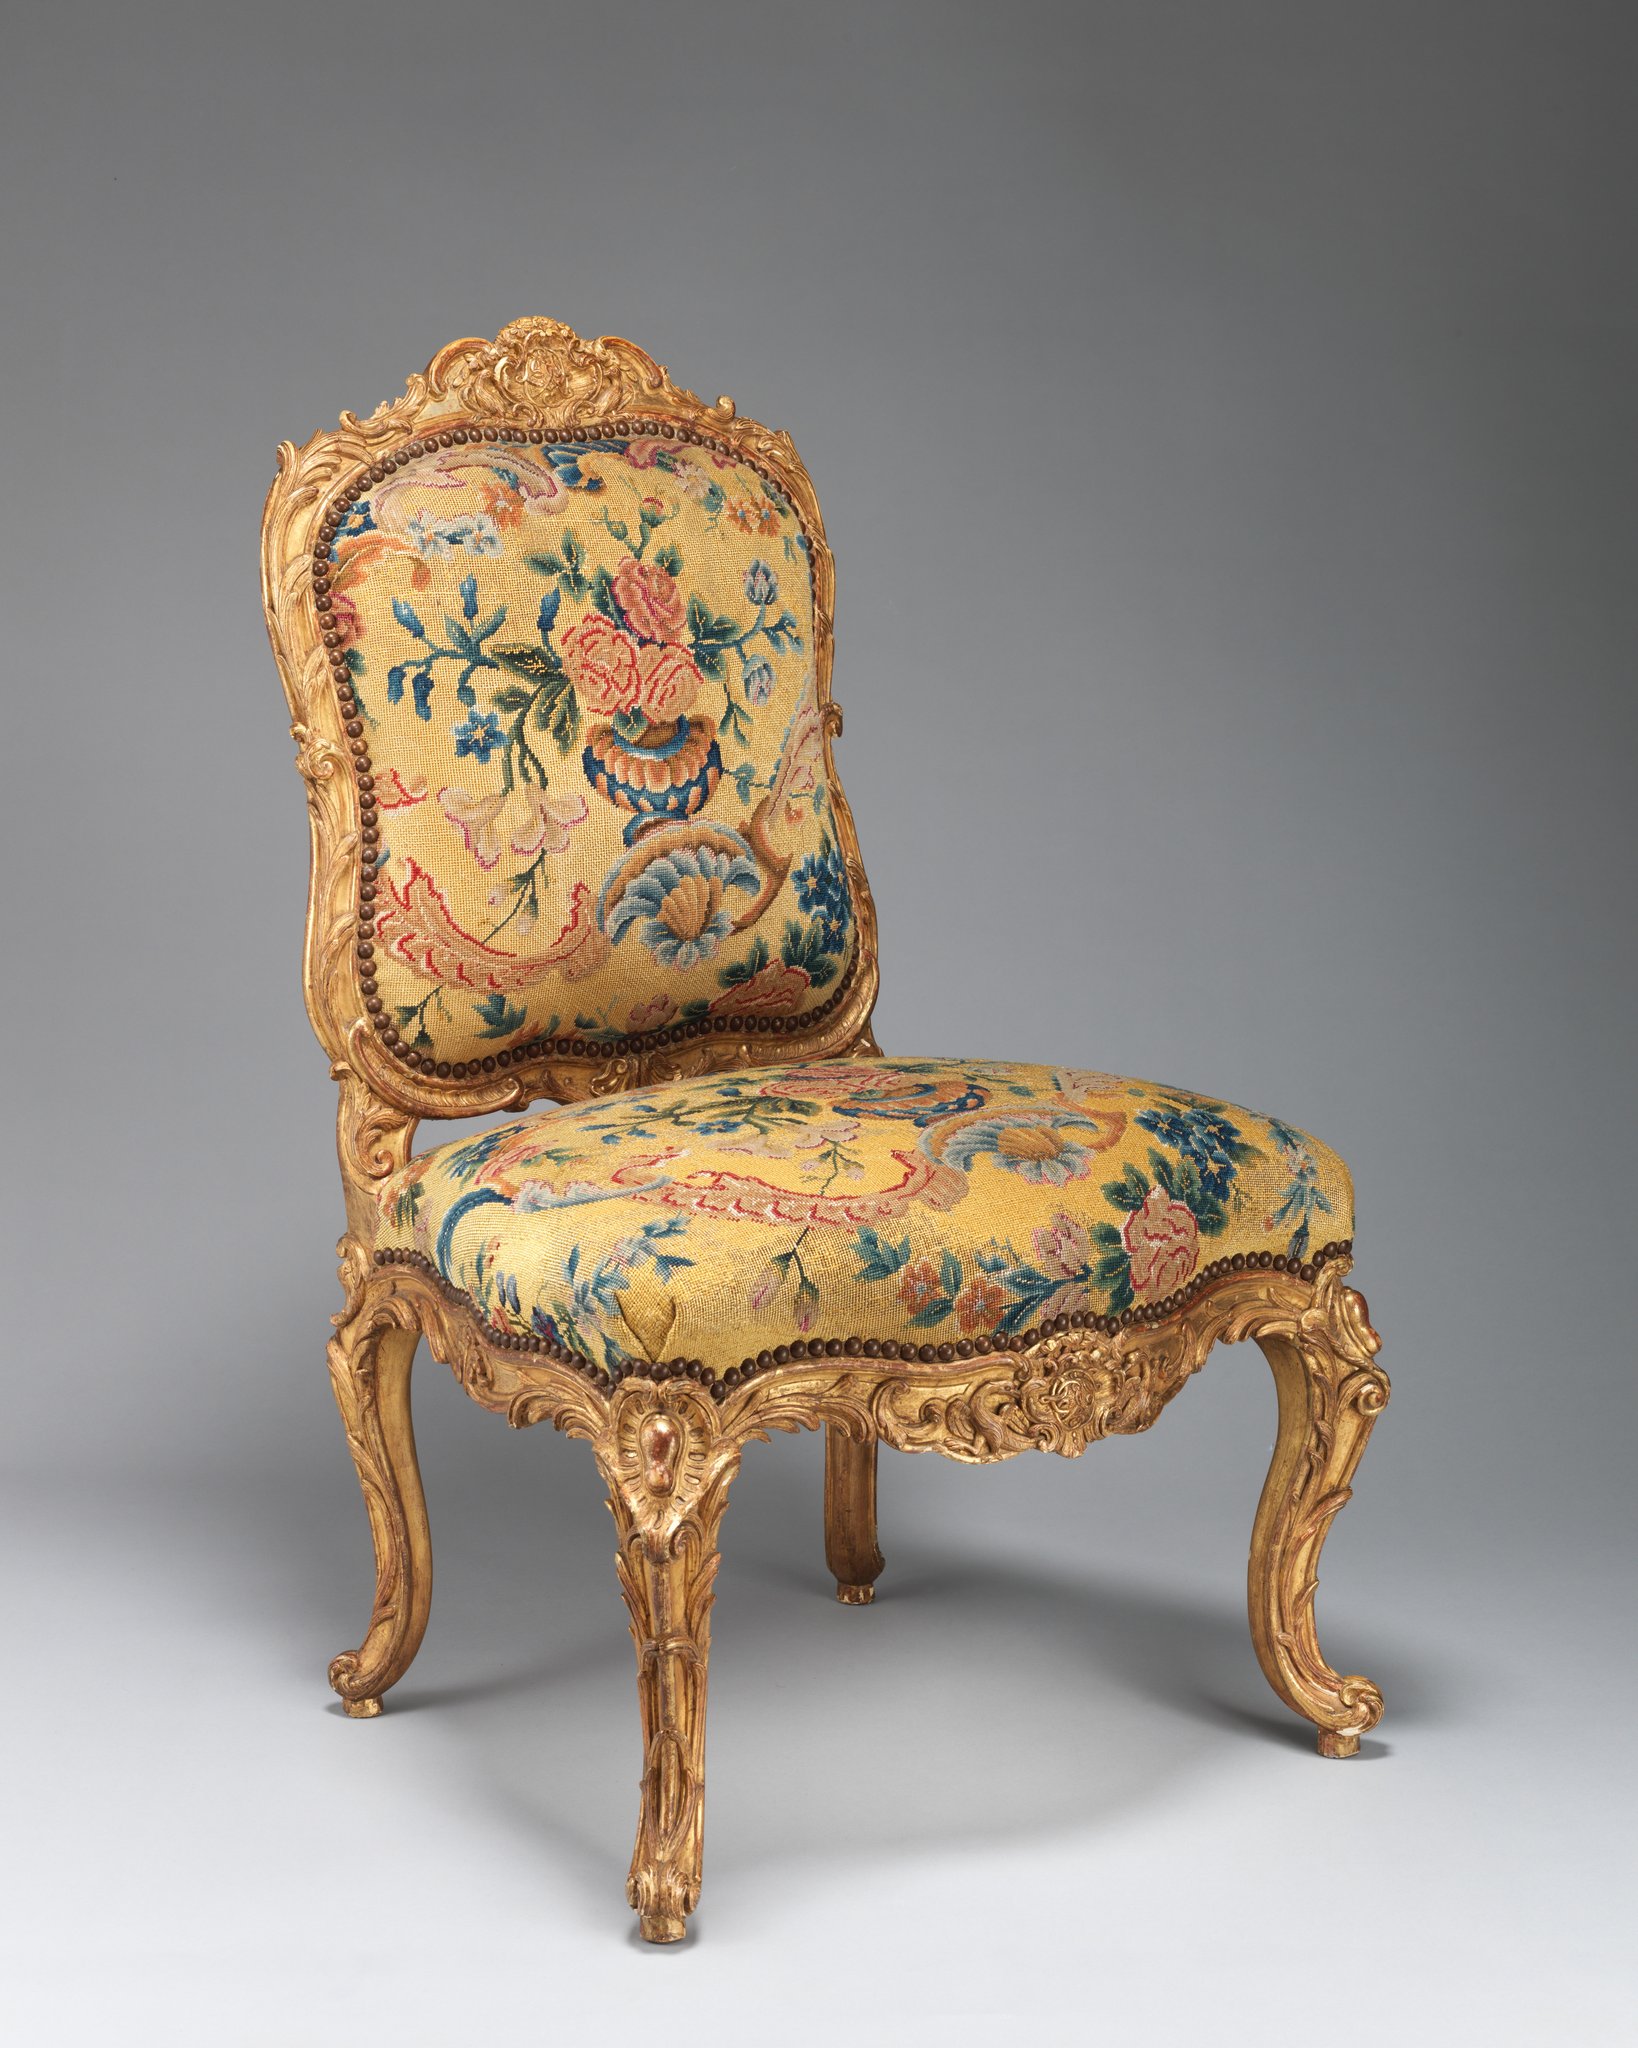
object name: chair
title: Chair (chaise à la Reine) (one of a set of four)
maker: jean-baptiste i tilliard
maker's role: maker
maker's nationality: french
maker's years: 1686-1766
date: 1745-1750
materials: wood, brass, coral, velvet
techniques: carving, gilding